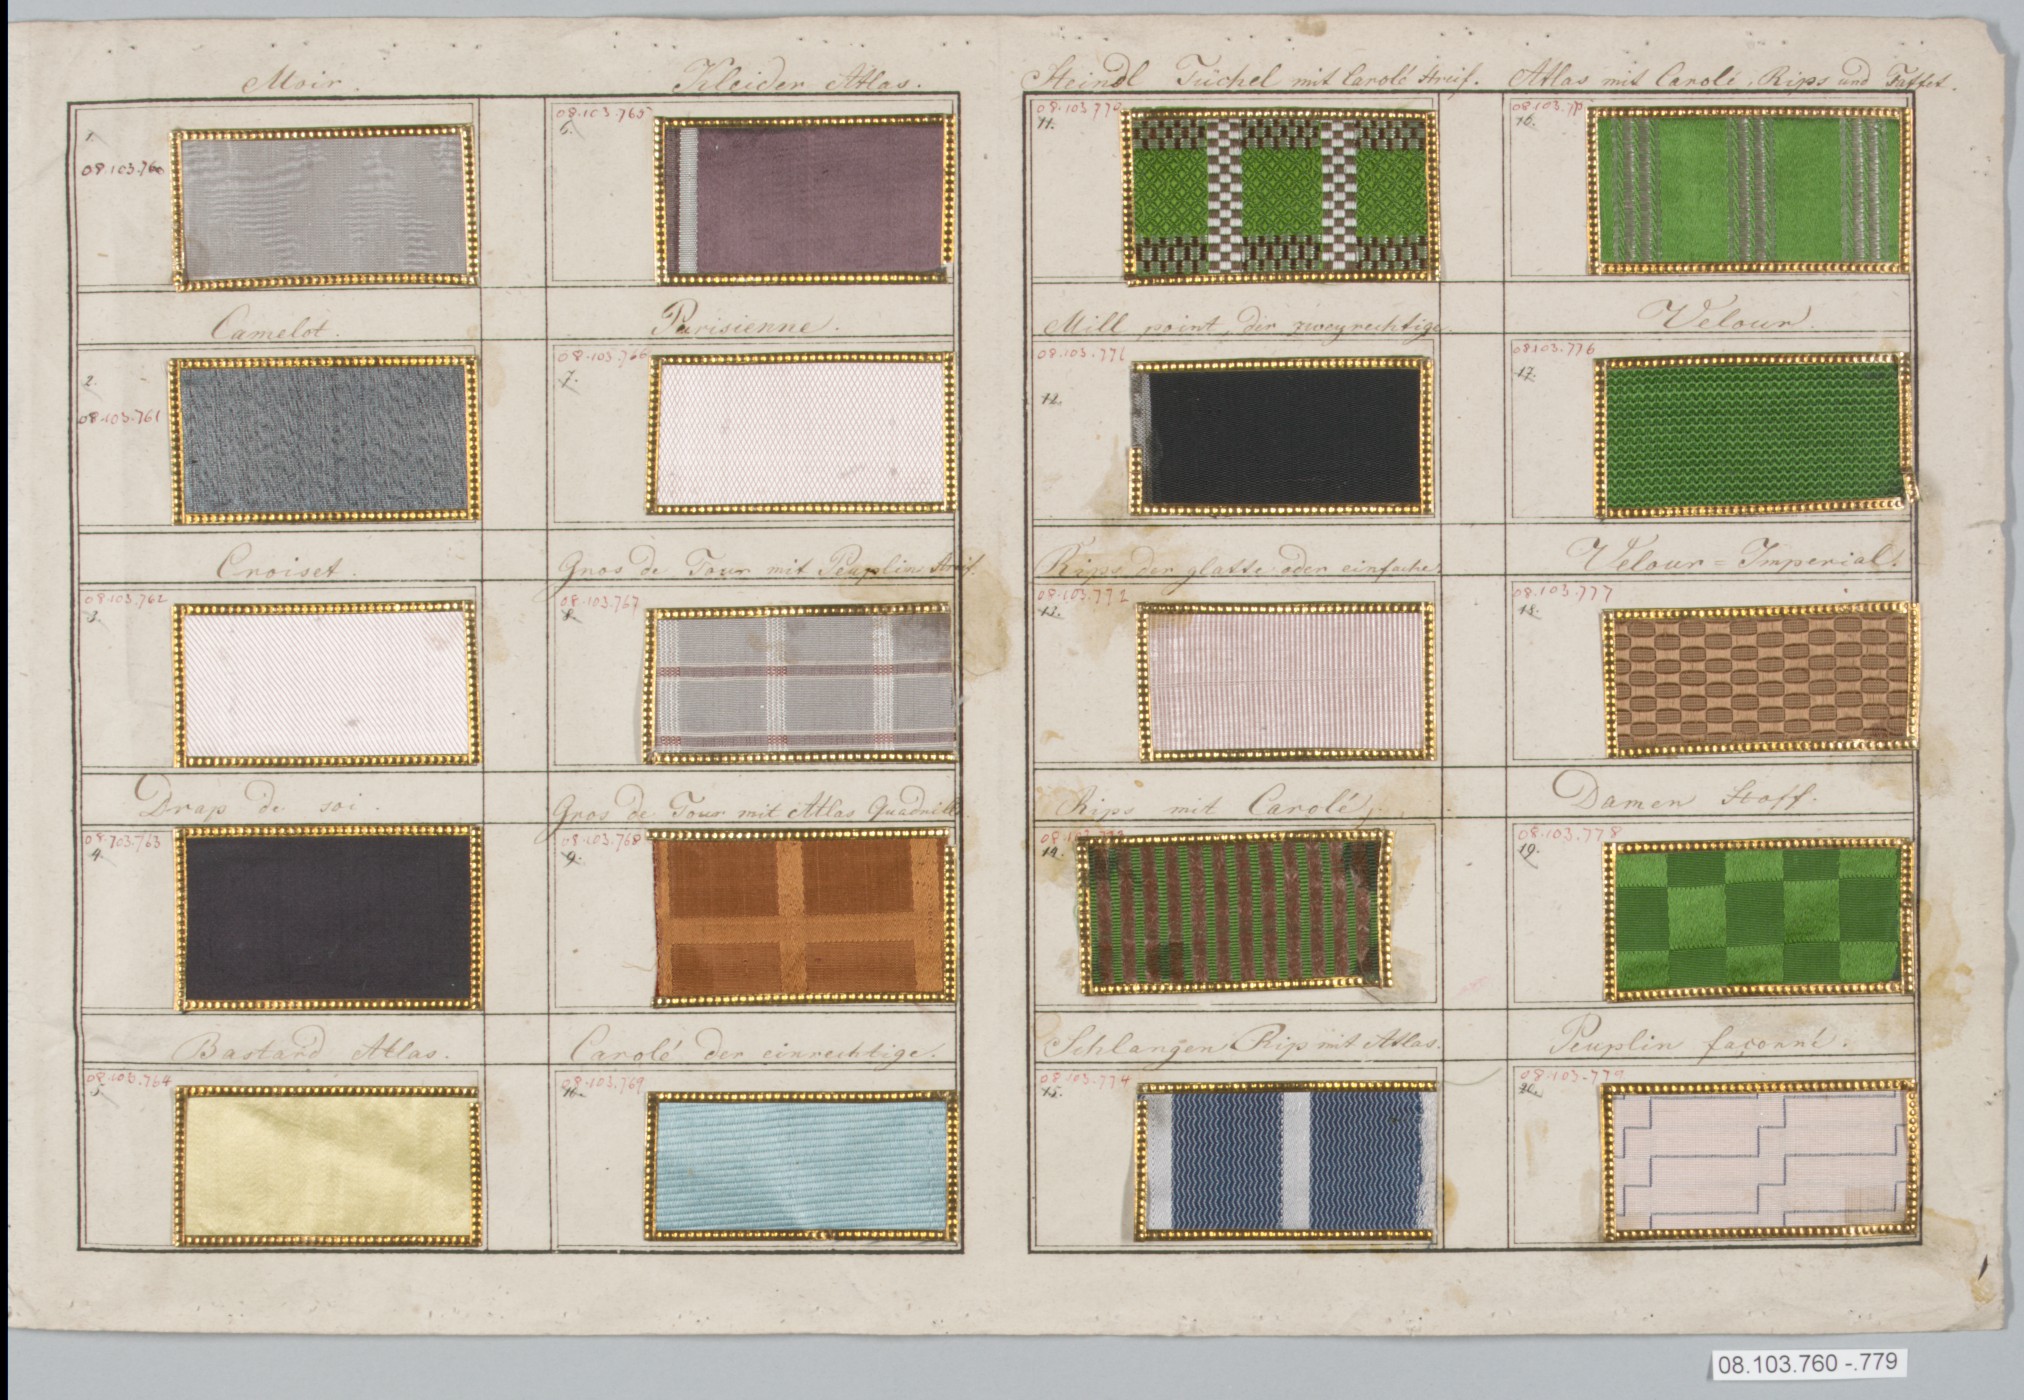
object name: ribbon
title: Ribbons (20)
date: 1701-1900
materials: silk